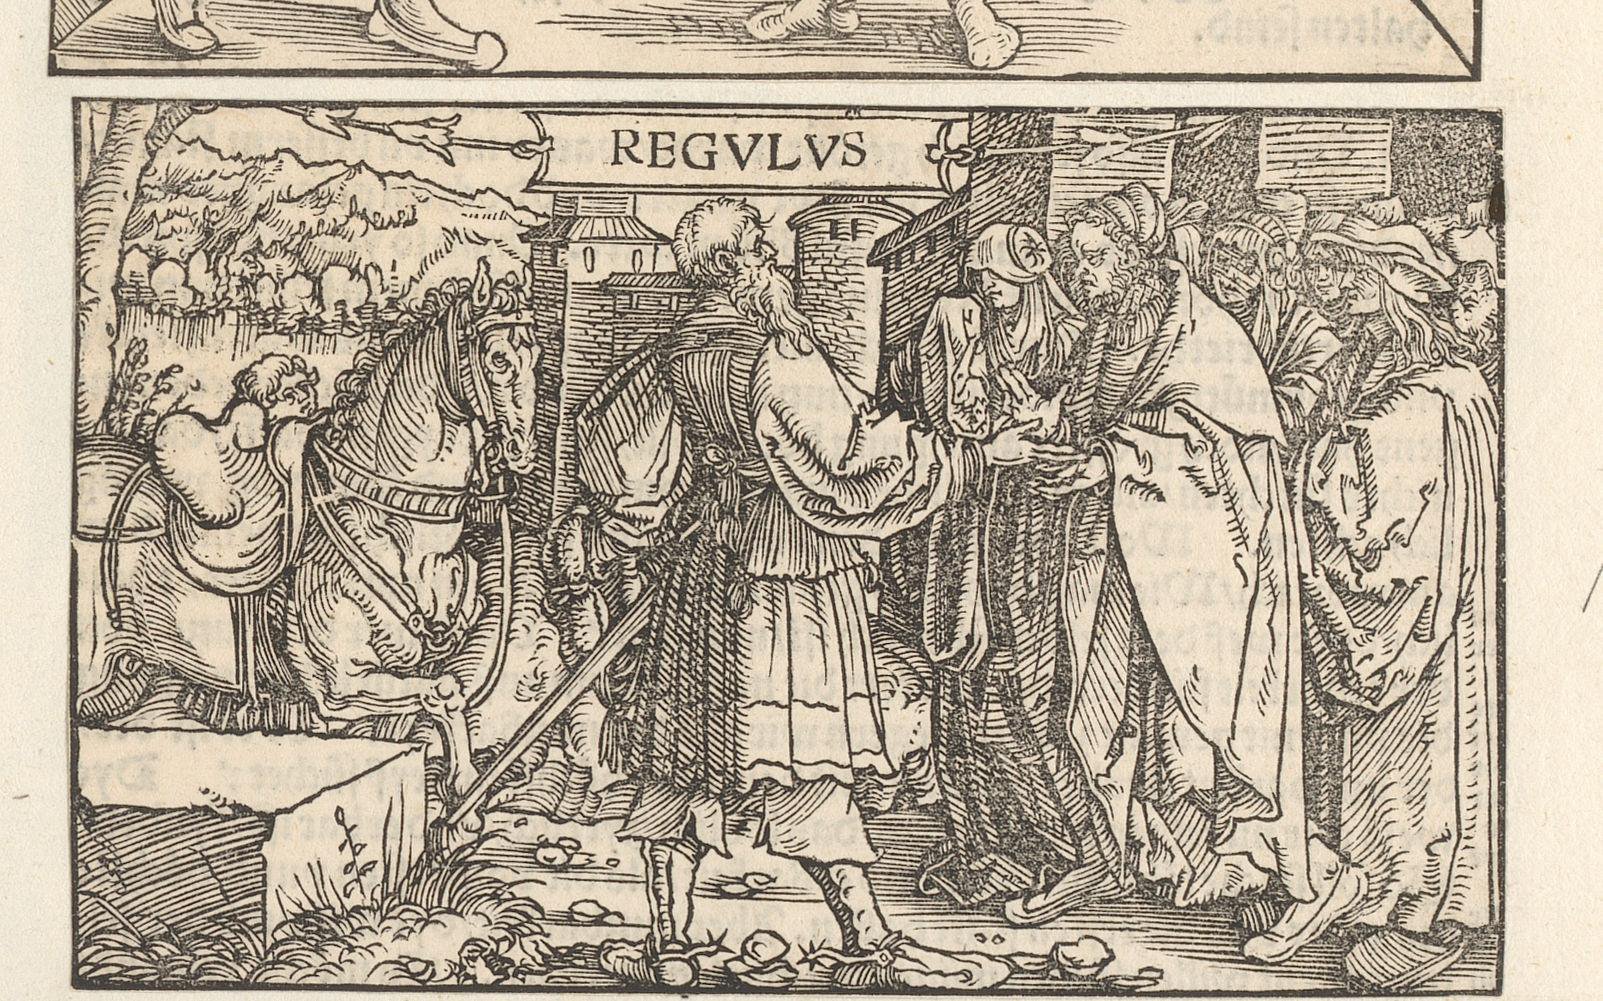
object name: album leaf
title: Regulus neemt afscheid voordat hij naar het vijandige kamp vertrekt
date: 1514-1531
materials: paper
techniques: letterpress printing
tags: surprise attack (stratagem)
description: Deze prent is gebruikt in: Cicero, Marcus Tulius. Officia M.T.C. Ein Buch so Marcus Tullius Cicero der Römer zu seynem (...). [Vertaald uit het Latijn door] Johann von Schwarzenberg. Augsburg: Heinrich Steiner, 1531.